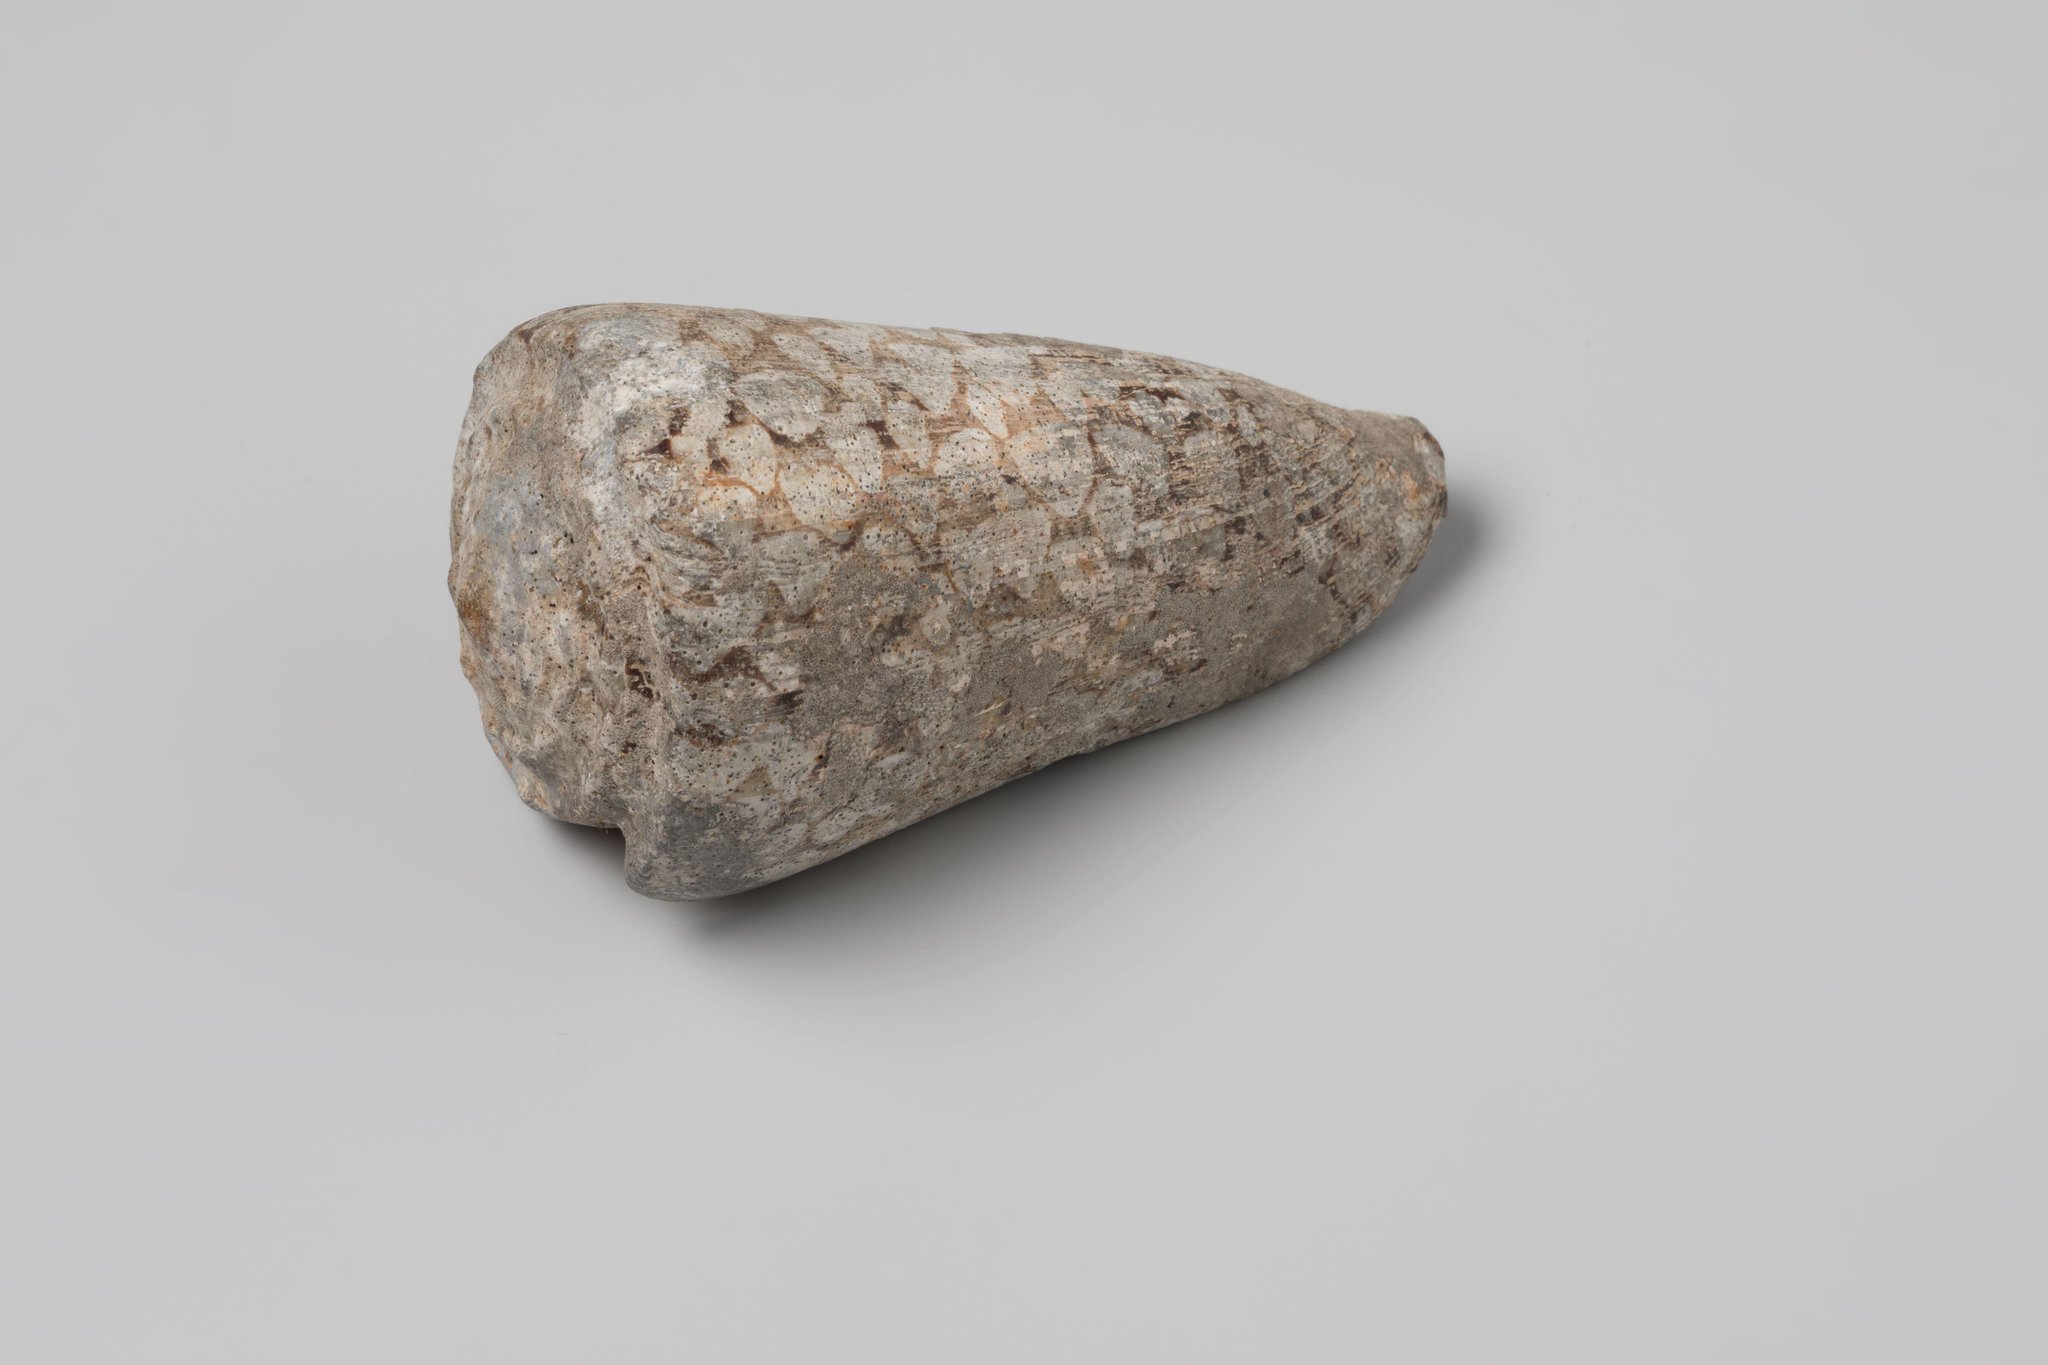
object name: conus marmoreus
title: Cornus marmoreus shell from the wreck of the Dutch East India ship Witte Leeuw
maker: niet van toepassing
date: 1613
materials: shell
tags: verenigde oostindische compagnie, sint-helena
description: Schelp uit V.O.C.-schip de 'Witte Leeuw'.